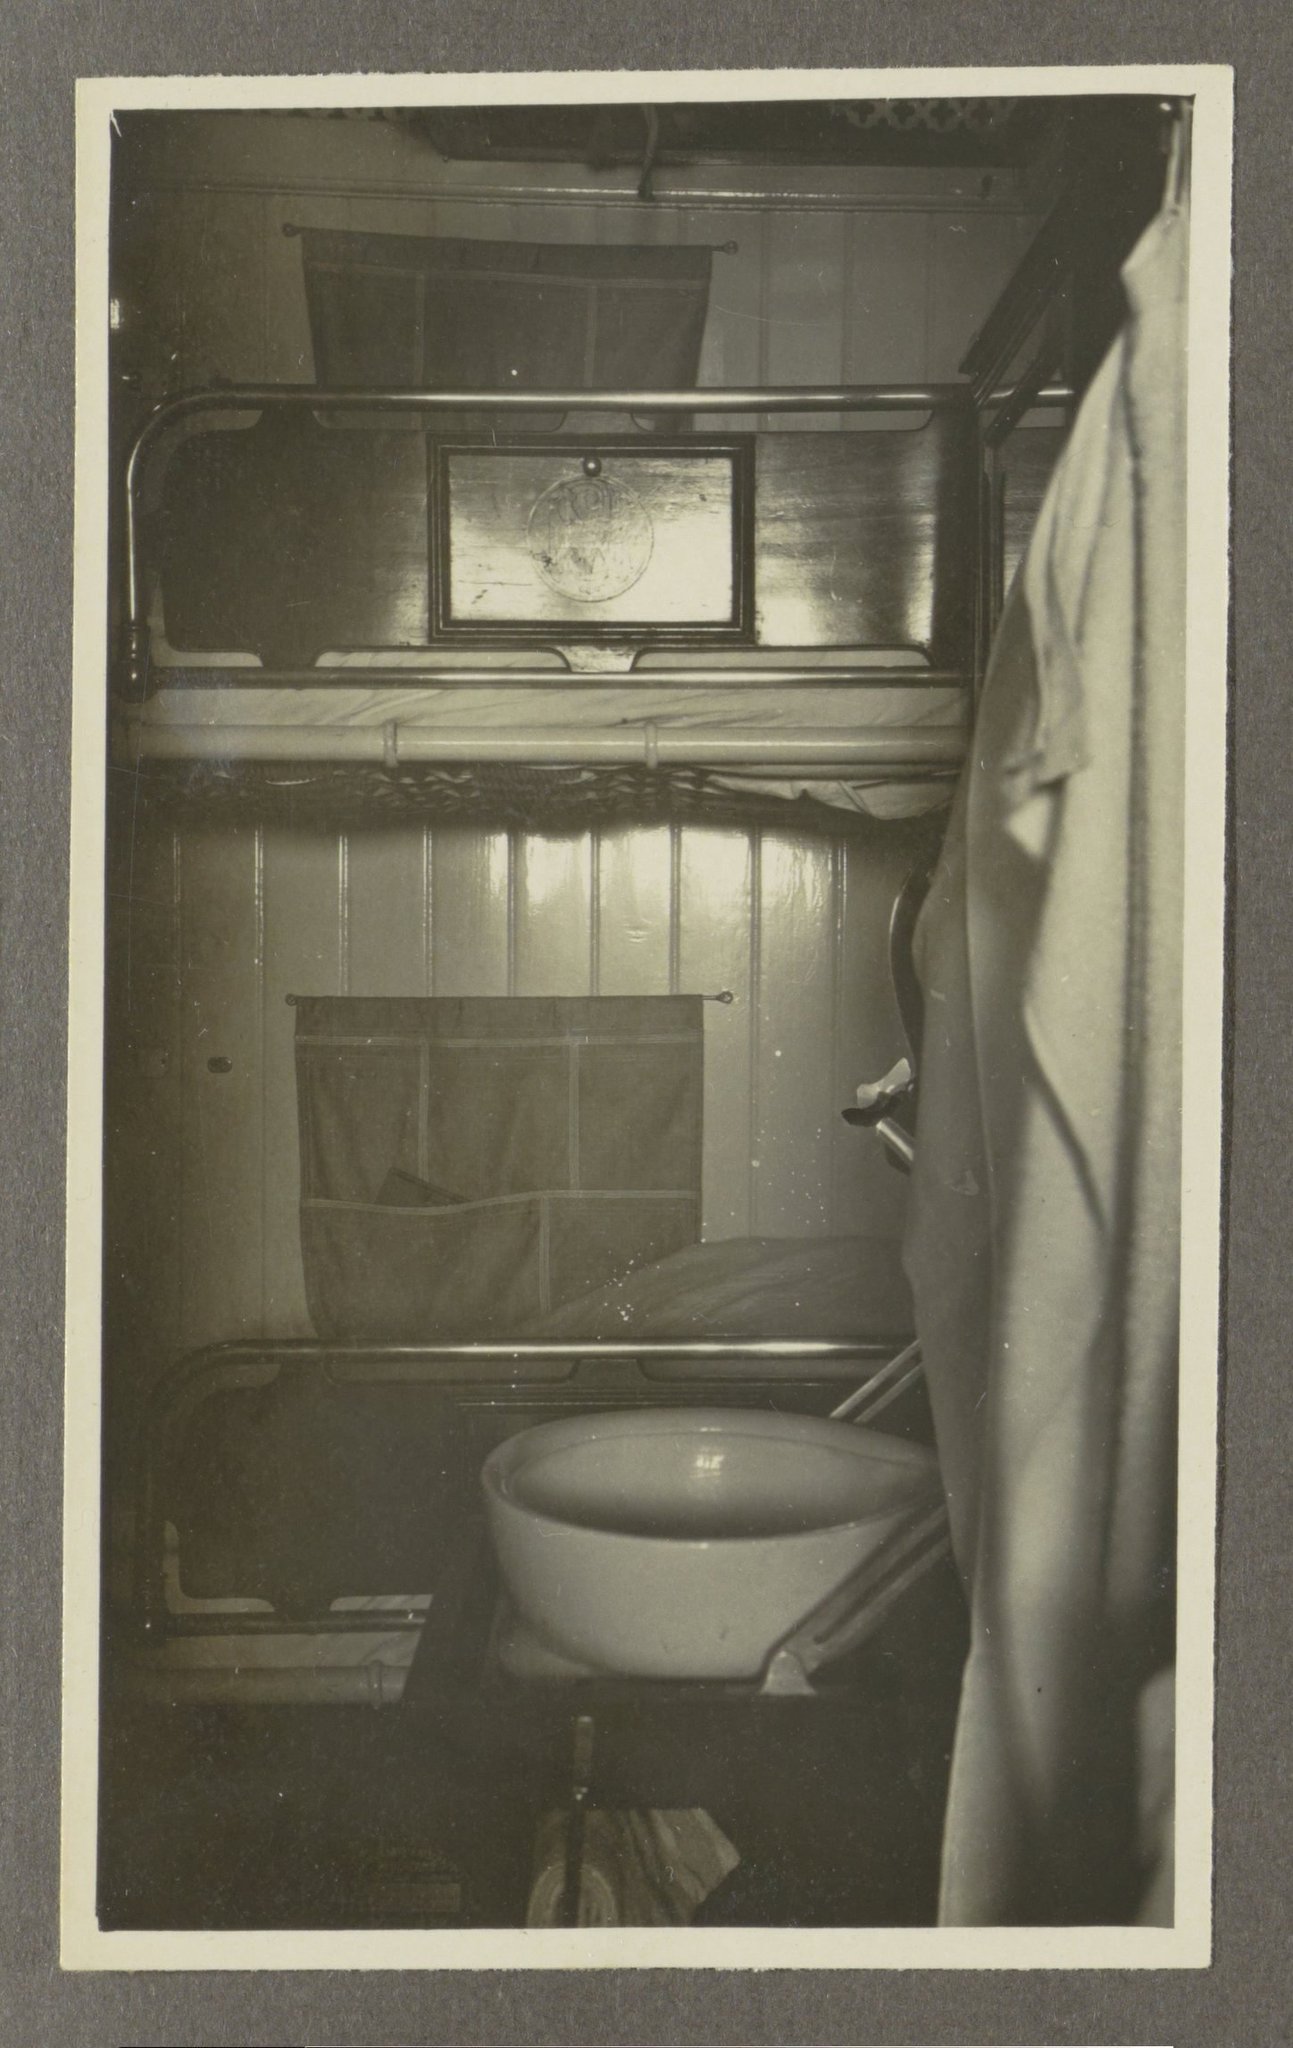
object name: photograph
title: Interieur van een scheepshut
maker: Anonymous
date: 1920-1930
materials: photographic support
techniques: gelatin silver print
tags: parts of ship's interior (with name)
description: Onderdeel van familiealbum Nederlands-Indië.